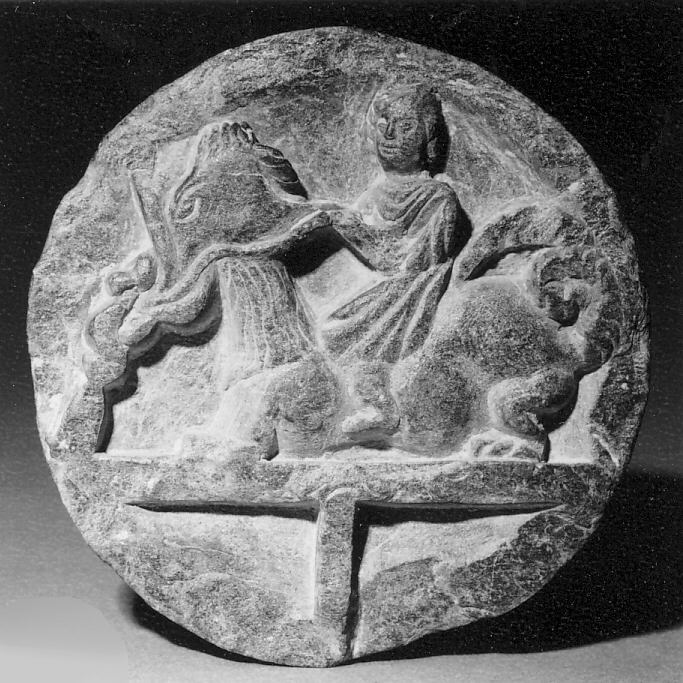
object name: dish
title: Dish with Sea Monster Bearing a Female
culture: gandhara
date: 100 BCE-100 CE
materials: stone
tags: gandhara,women,monsters